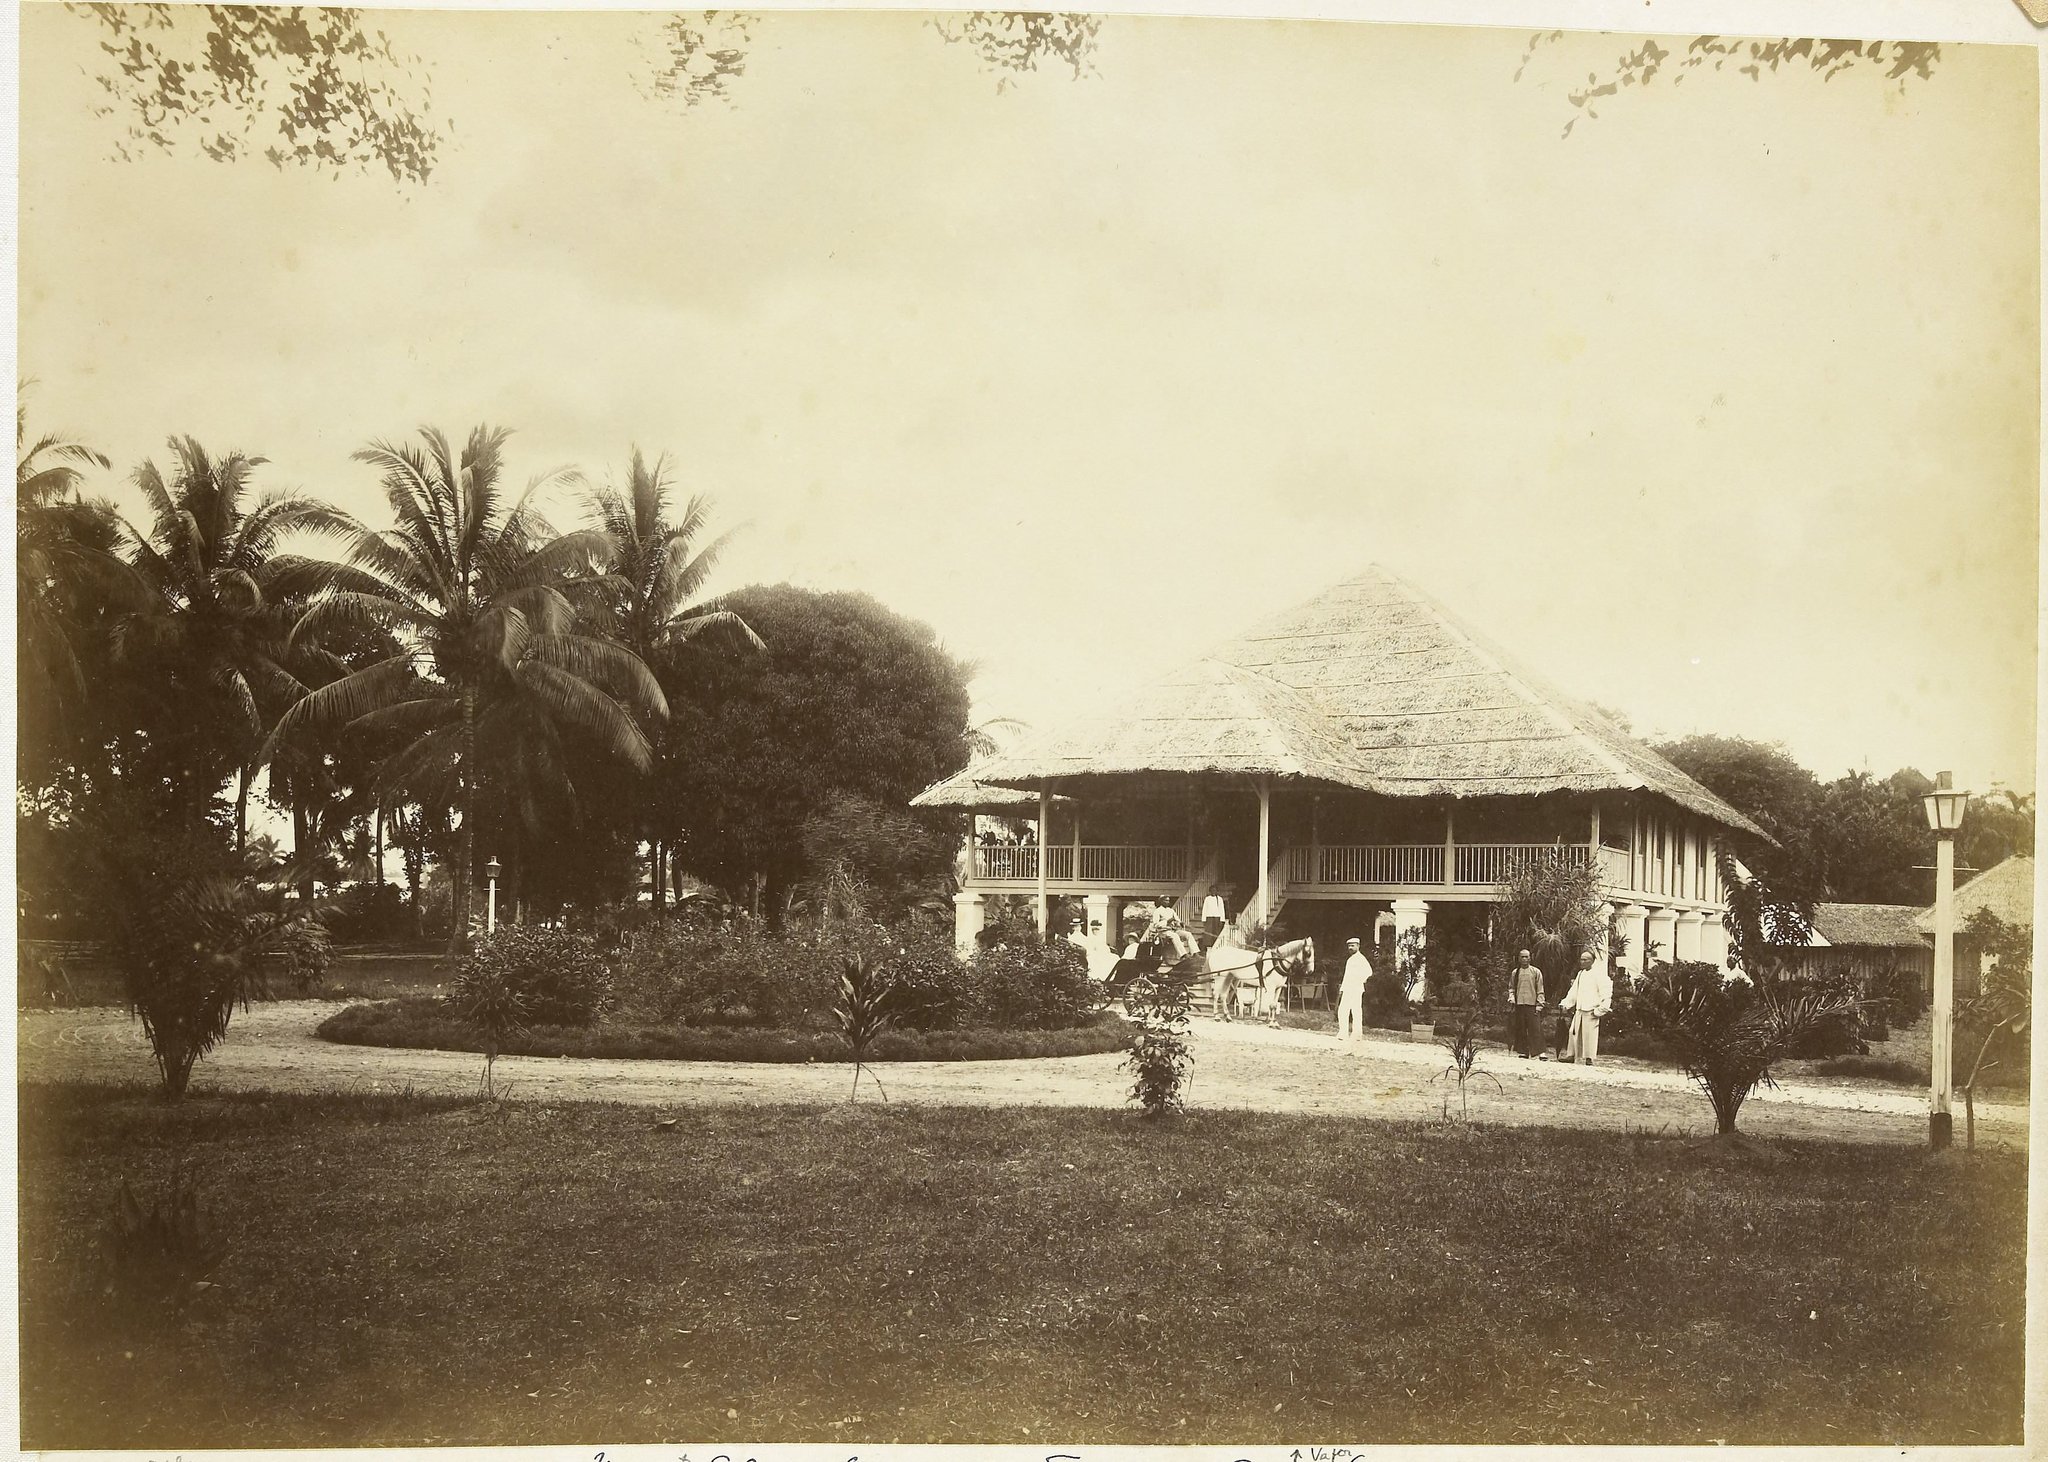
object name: photograph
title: Paul Sandel voor zijn huis in Tandjong Poera, Langkat Sumatra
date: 1900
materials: cardboard, paper, photographic support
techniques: albumen print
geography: bindjai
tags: sumatra